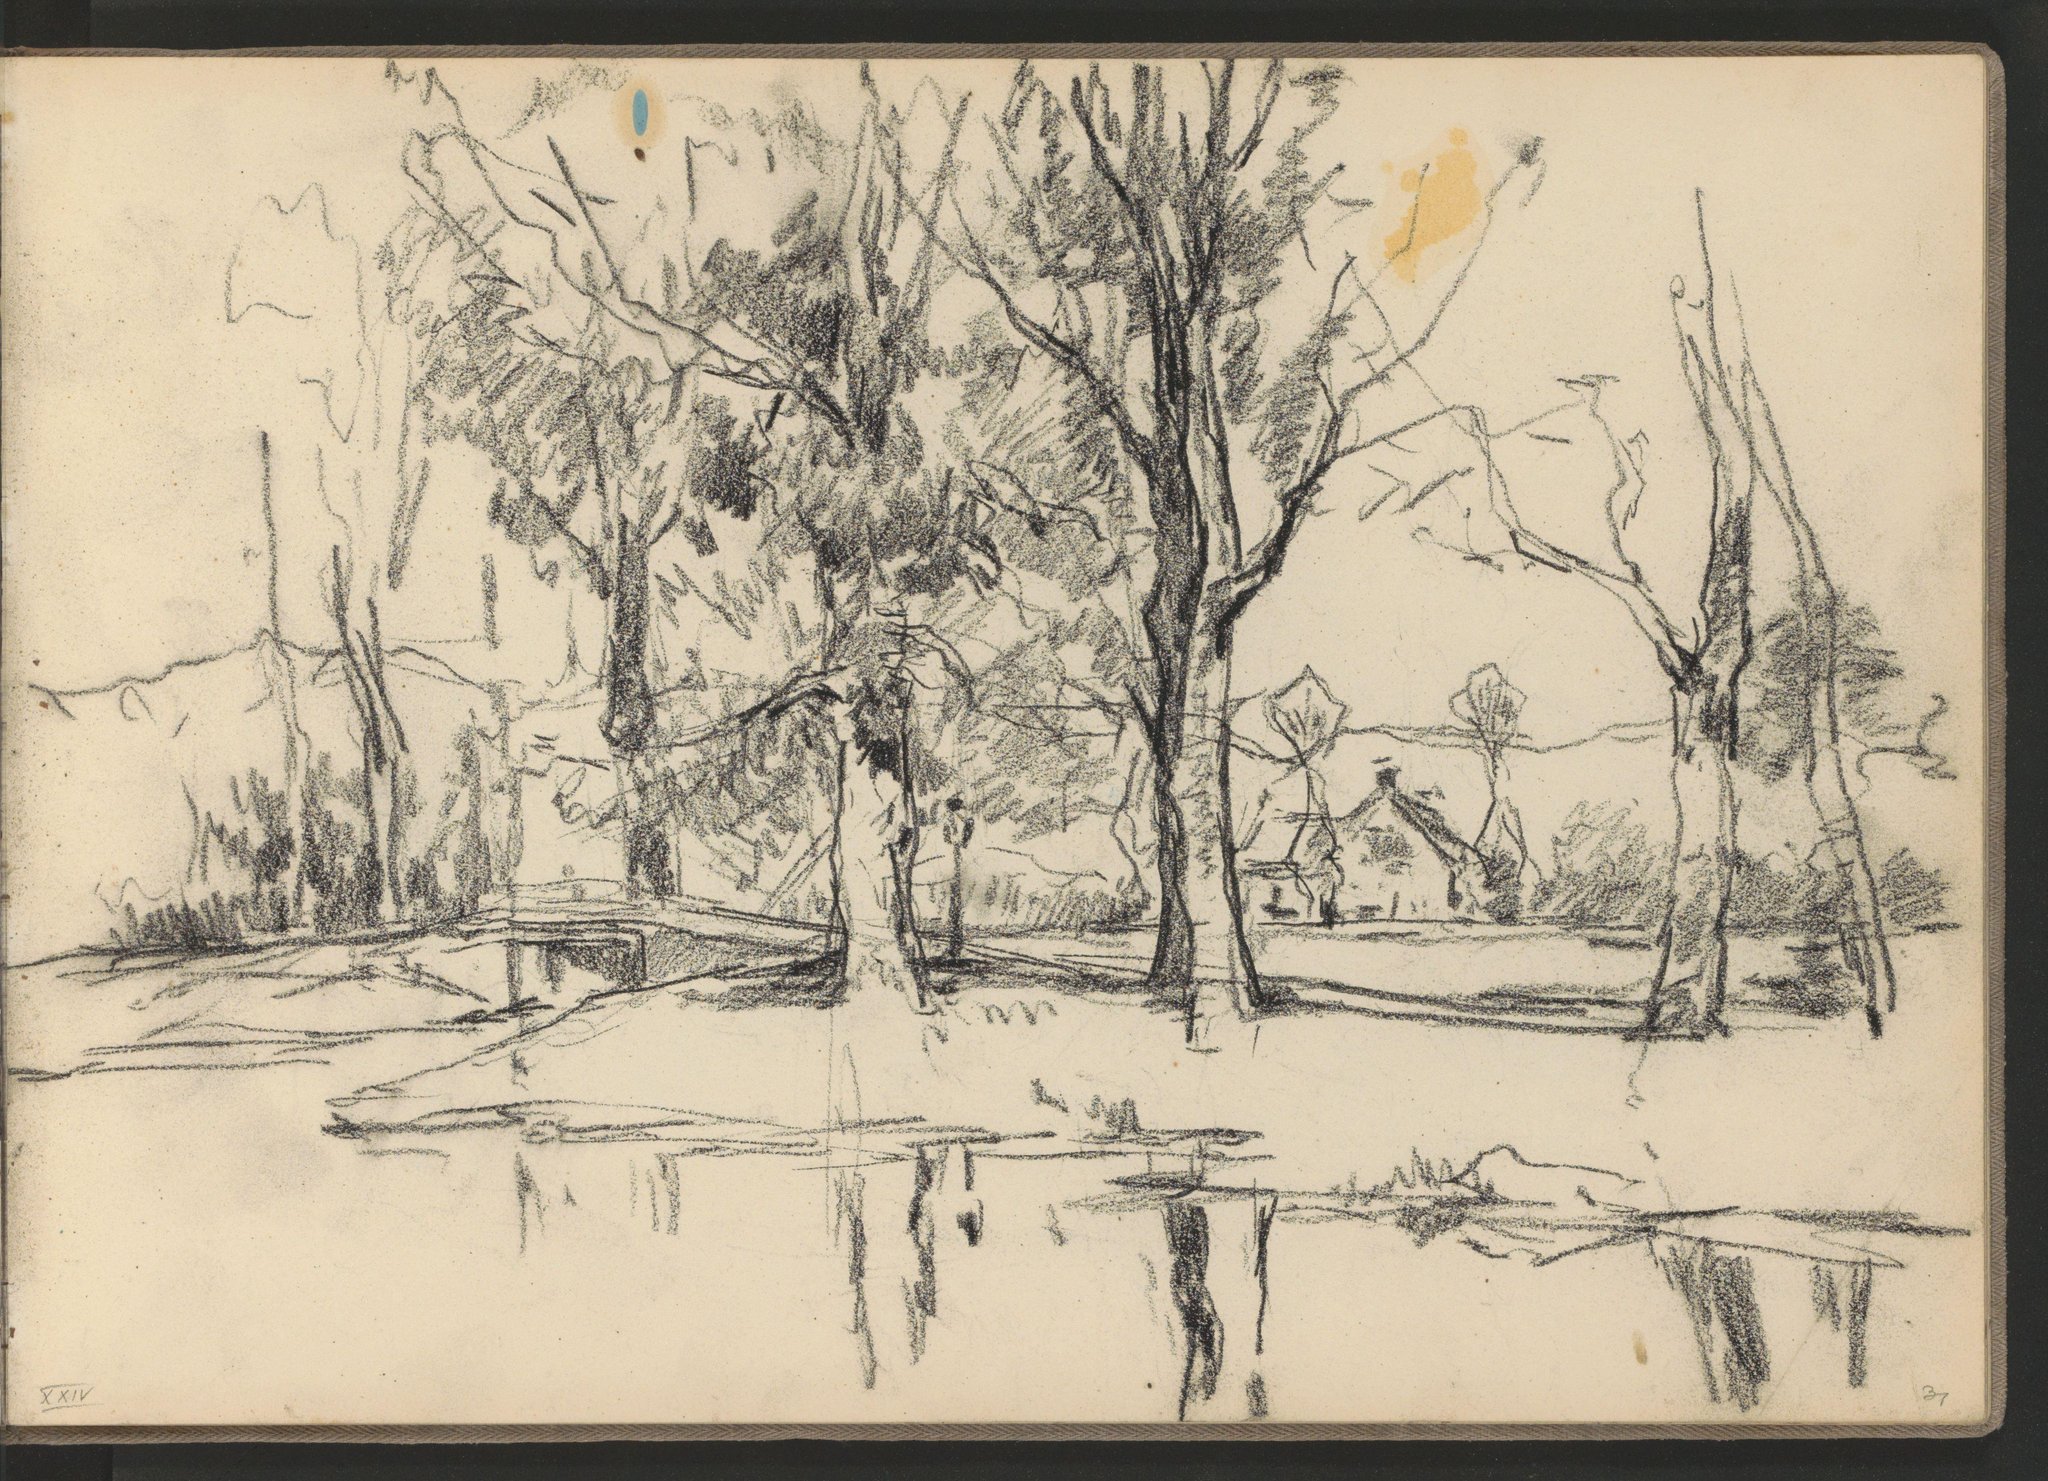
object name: sketchbook leaf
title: Bomen aan een waterkant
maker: egbert rubertus derk schaap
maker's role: draughtsman, painter, print maker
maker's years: 1862-1939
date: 1891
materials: chalk, paper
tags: trees, landscapes with waters, waterscapes, seascapes (in the temperate zone)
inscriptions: number: ‘XXIV’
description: Op de achtergrond een huis. Pagina 31 uit een schetsboek met 64 pagina's.